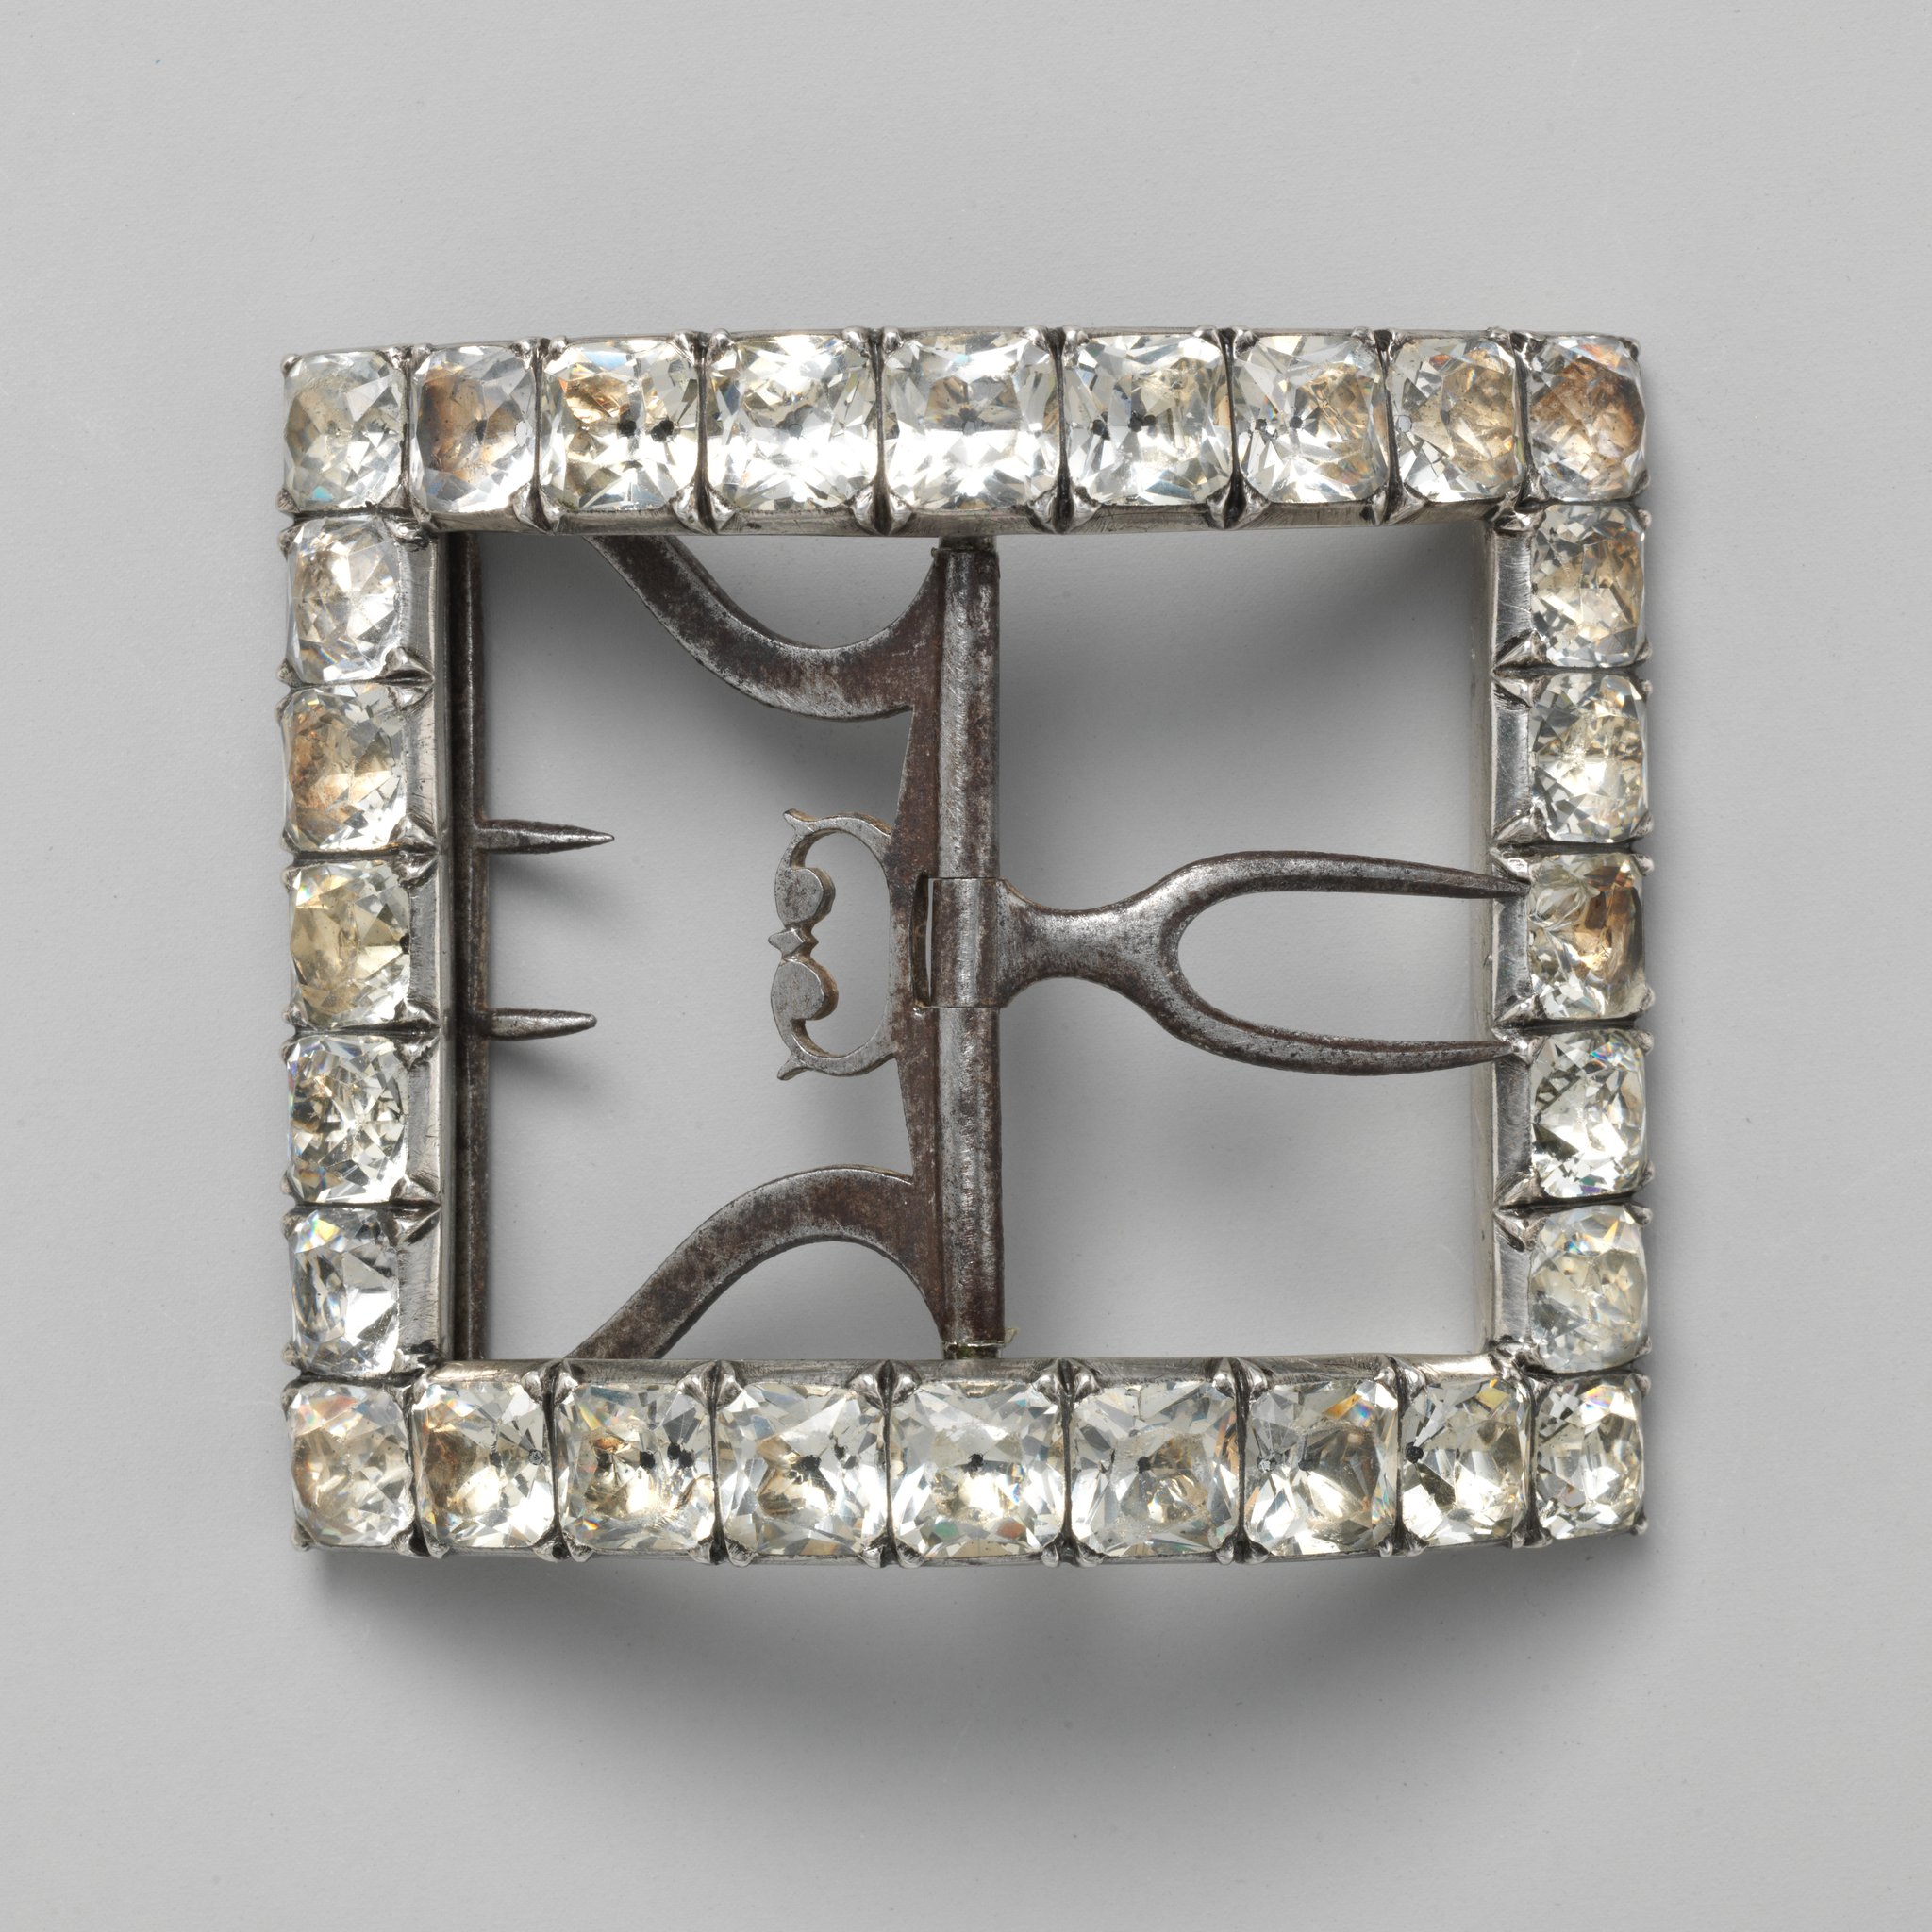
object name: shoe buckle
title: Shoe buckles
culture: british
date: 1767-1800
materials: metal, paste